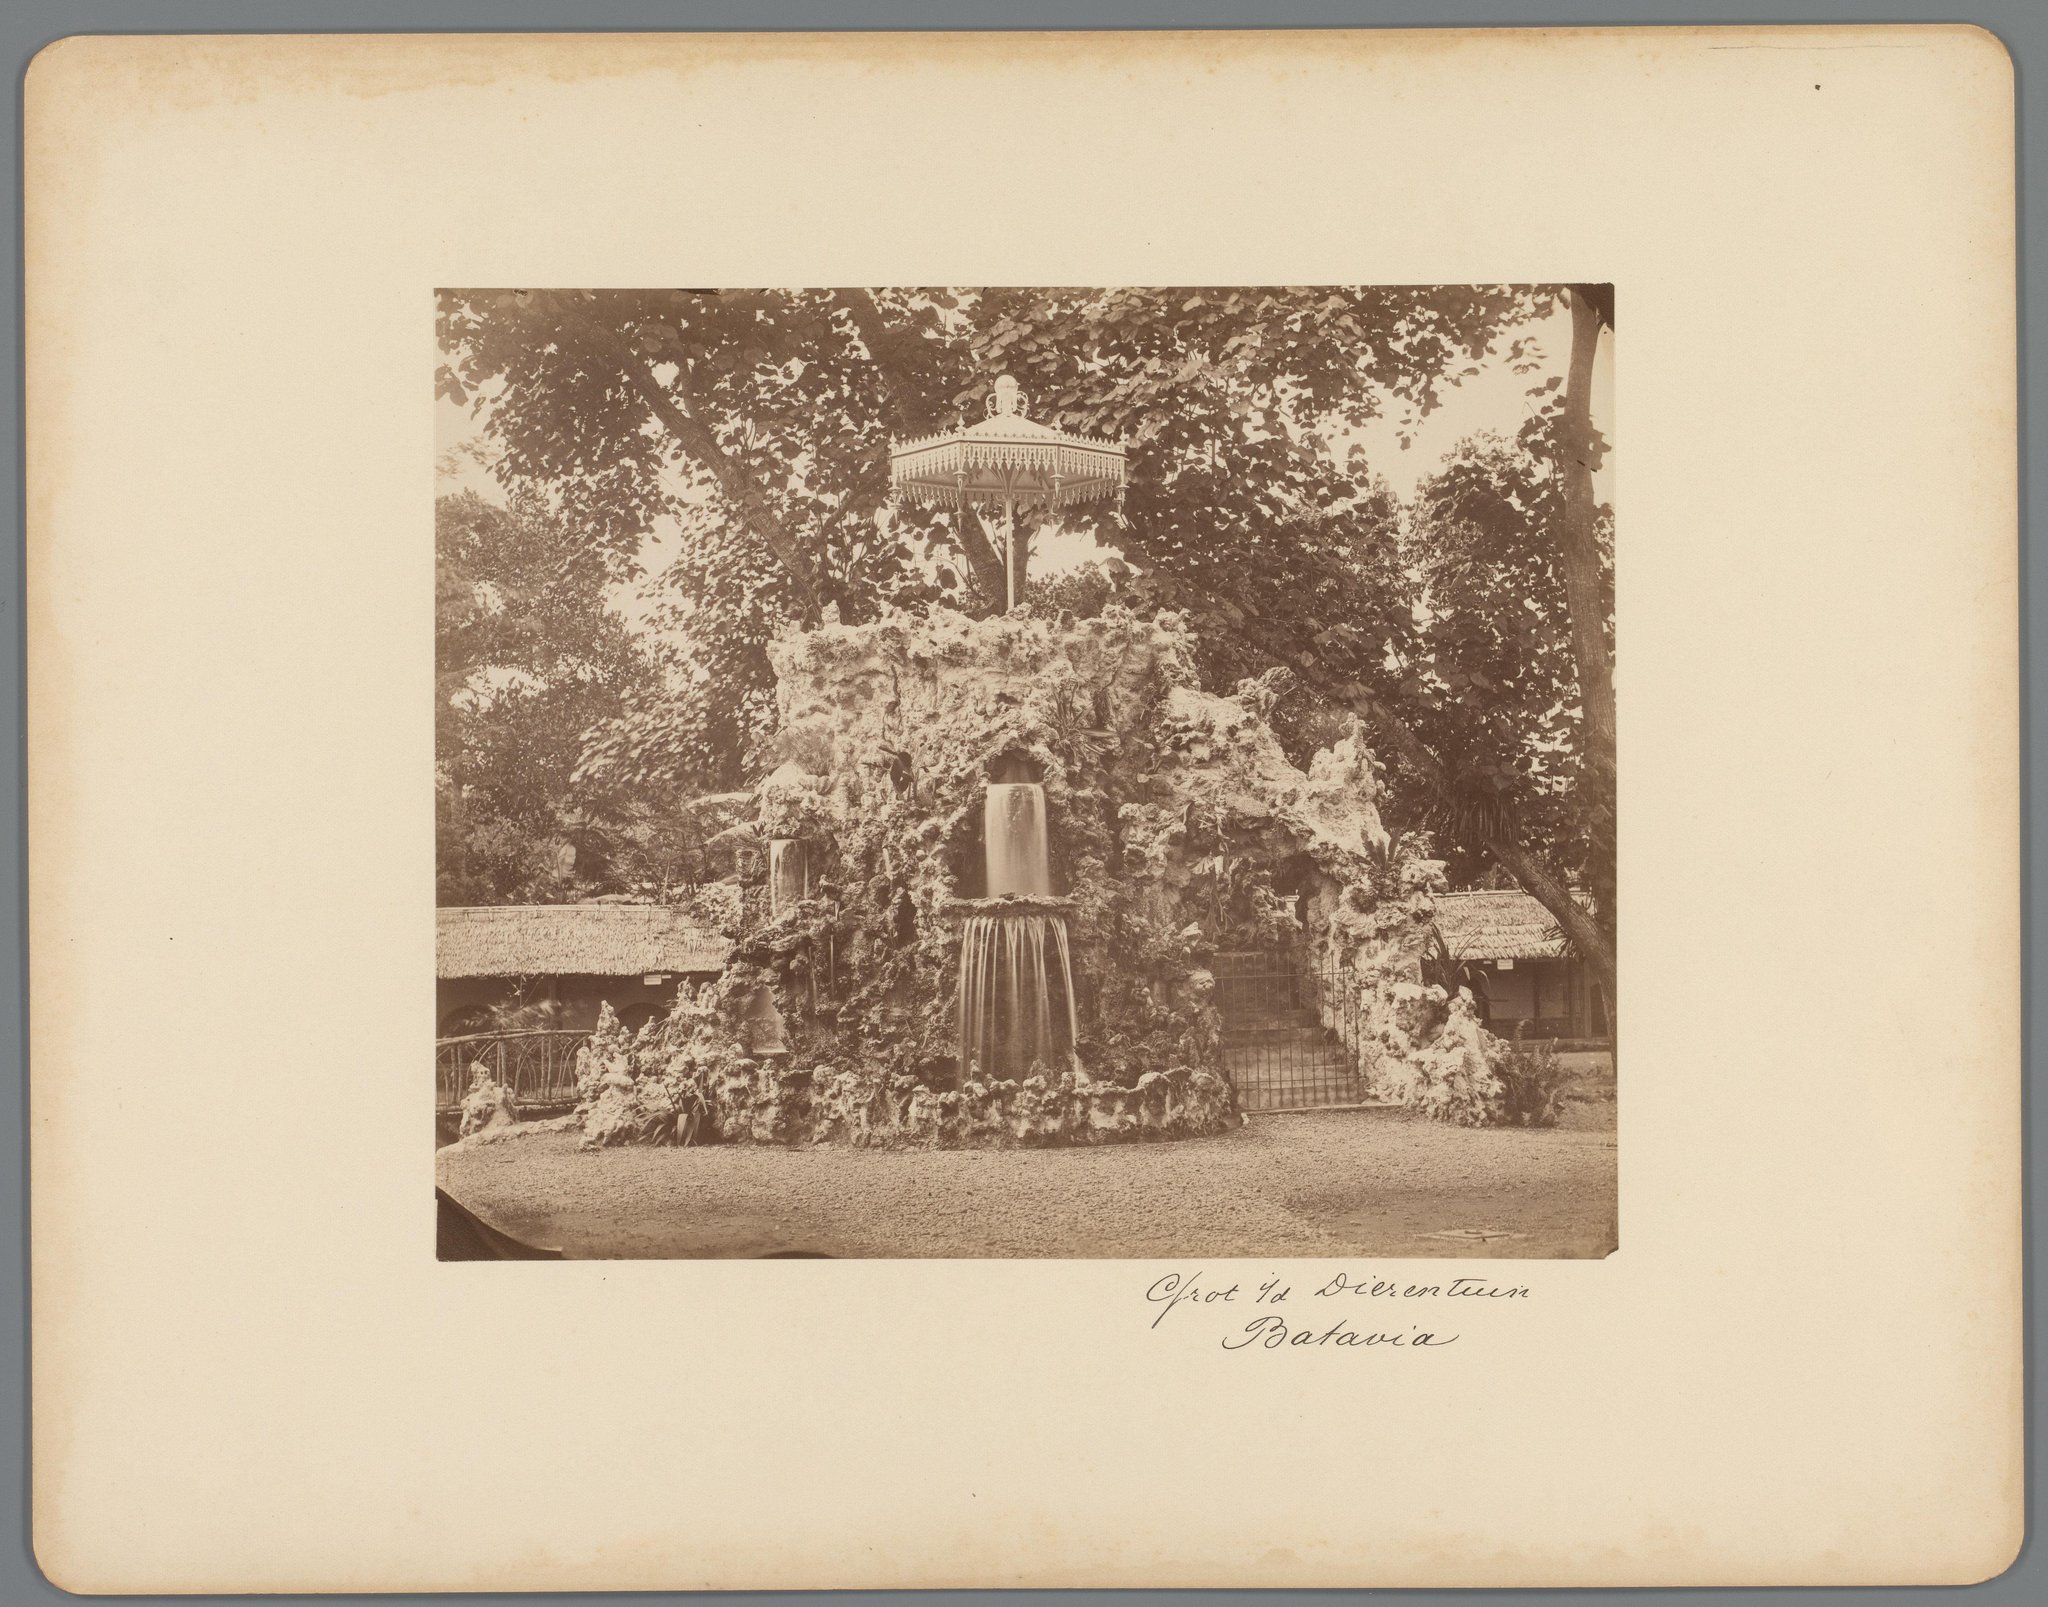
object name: photograph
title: Kunstmatige grot met waterval in de Planten- en Dierentuin te Batavia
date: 1864-1908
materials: cardboard, paper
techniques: albumen print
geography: batavia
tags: cave, grotto, zoological garden, zoo, seen as place where non-domestic animals are kept, garden cascade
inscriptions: inscription: ‘PHOTOGRAFIEEN VAN NED: INDIE BATAVIA’, inscription: ‘FOTO’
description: Deze foto zat oorspronkelijk in prentenkabinet RP-F-AA3192.